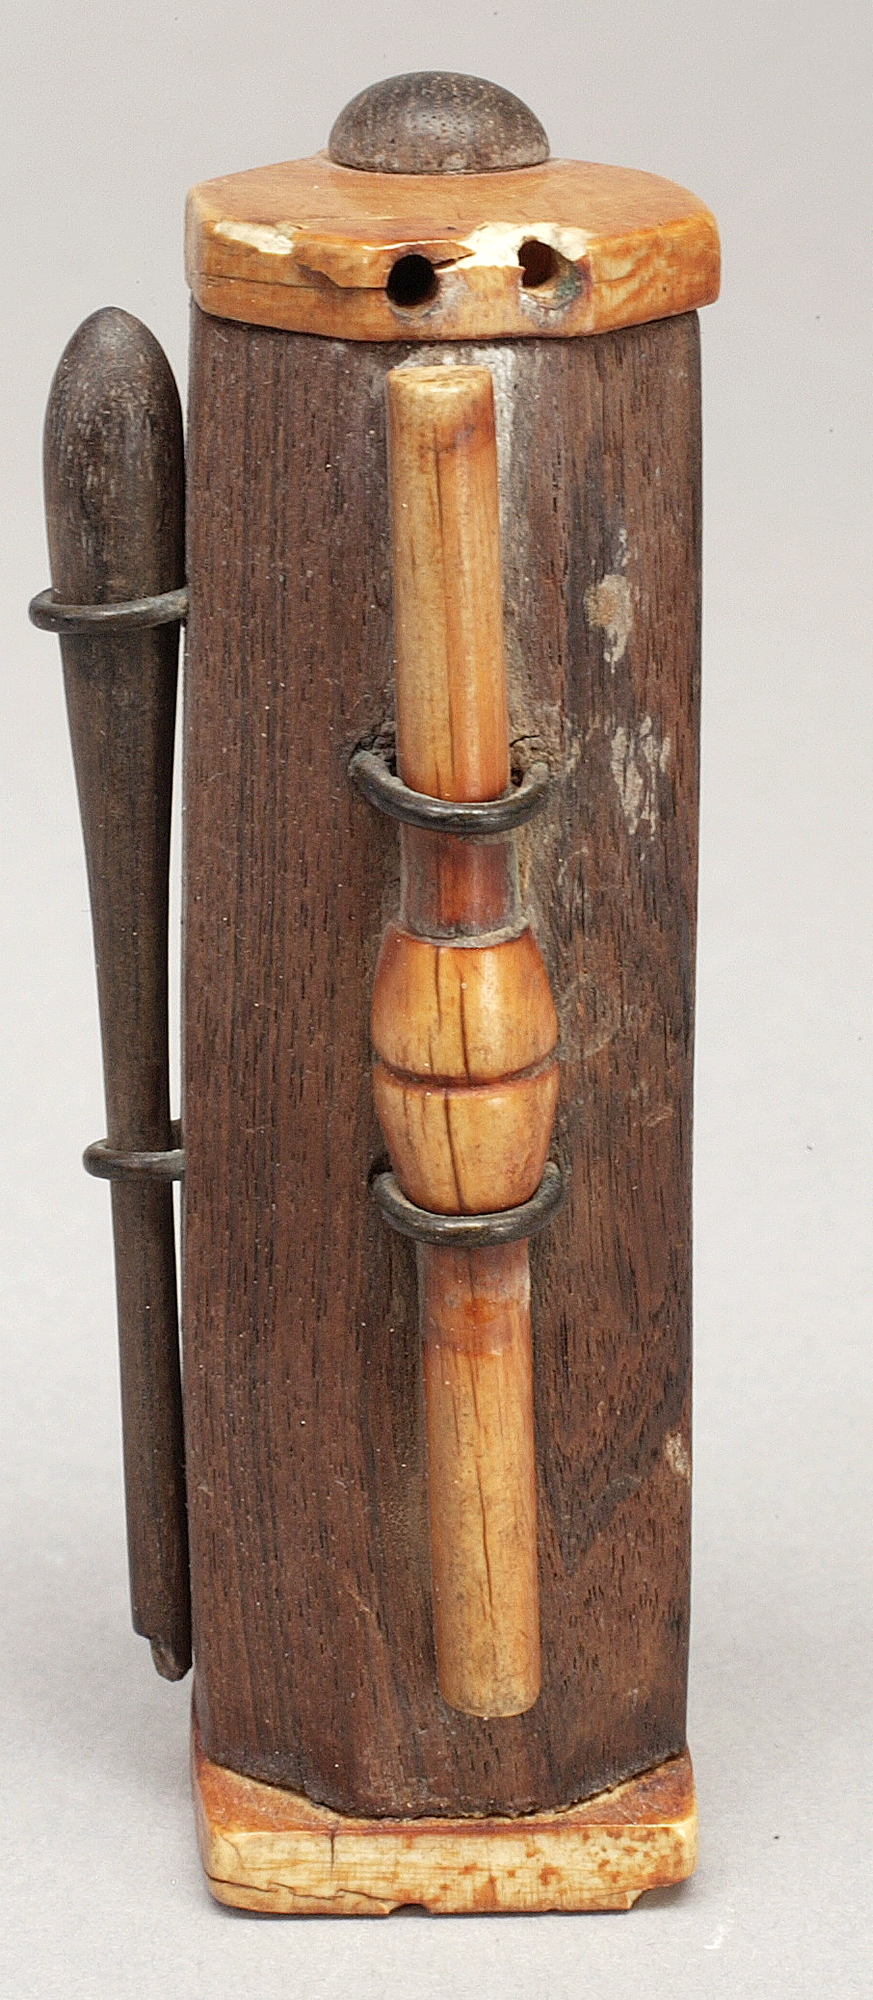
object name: kohl tube, stick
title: Kohl tube and stick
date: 1550-1458 BCE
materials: copper, wood, ivory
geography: egypt